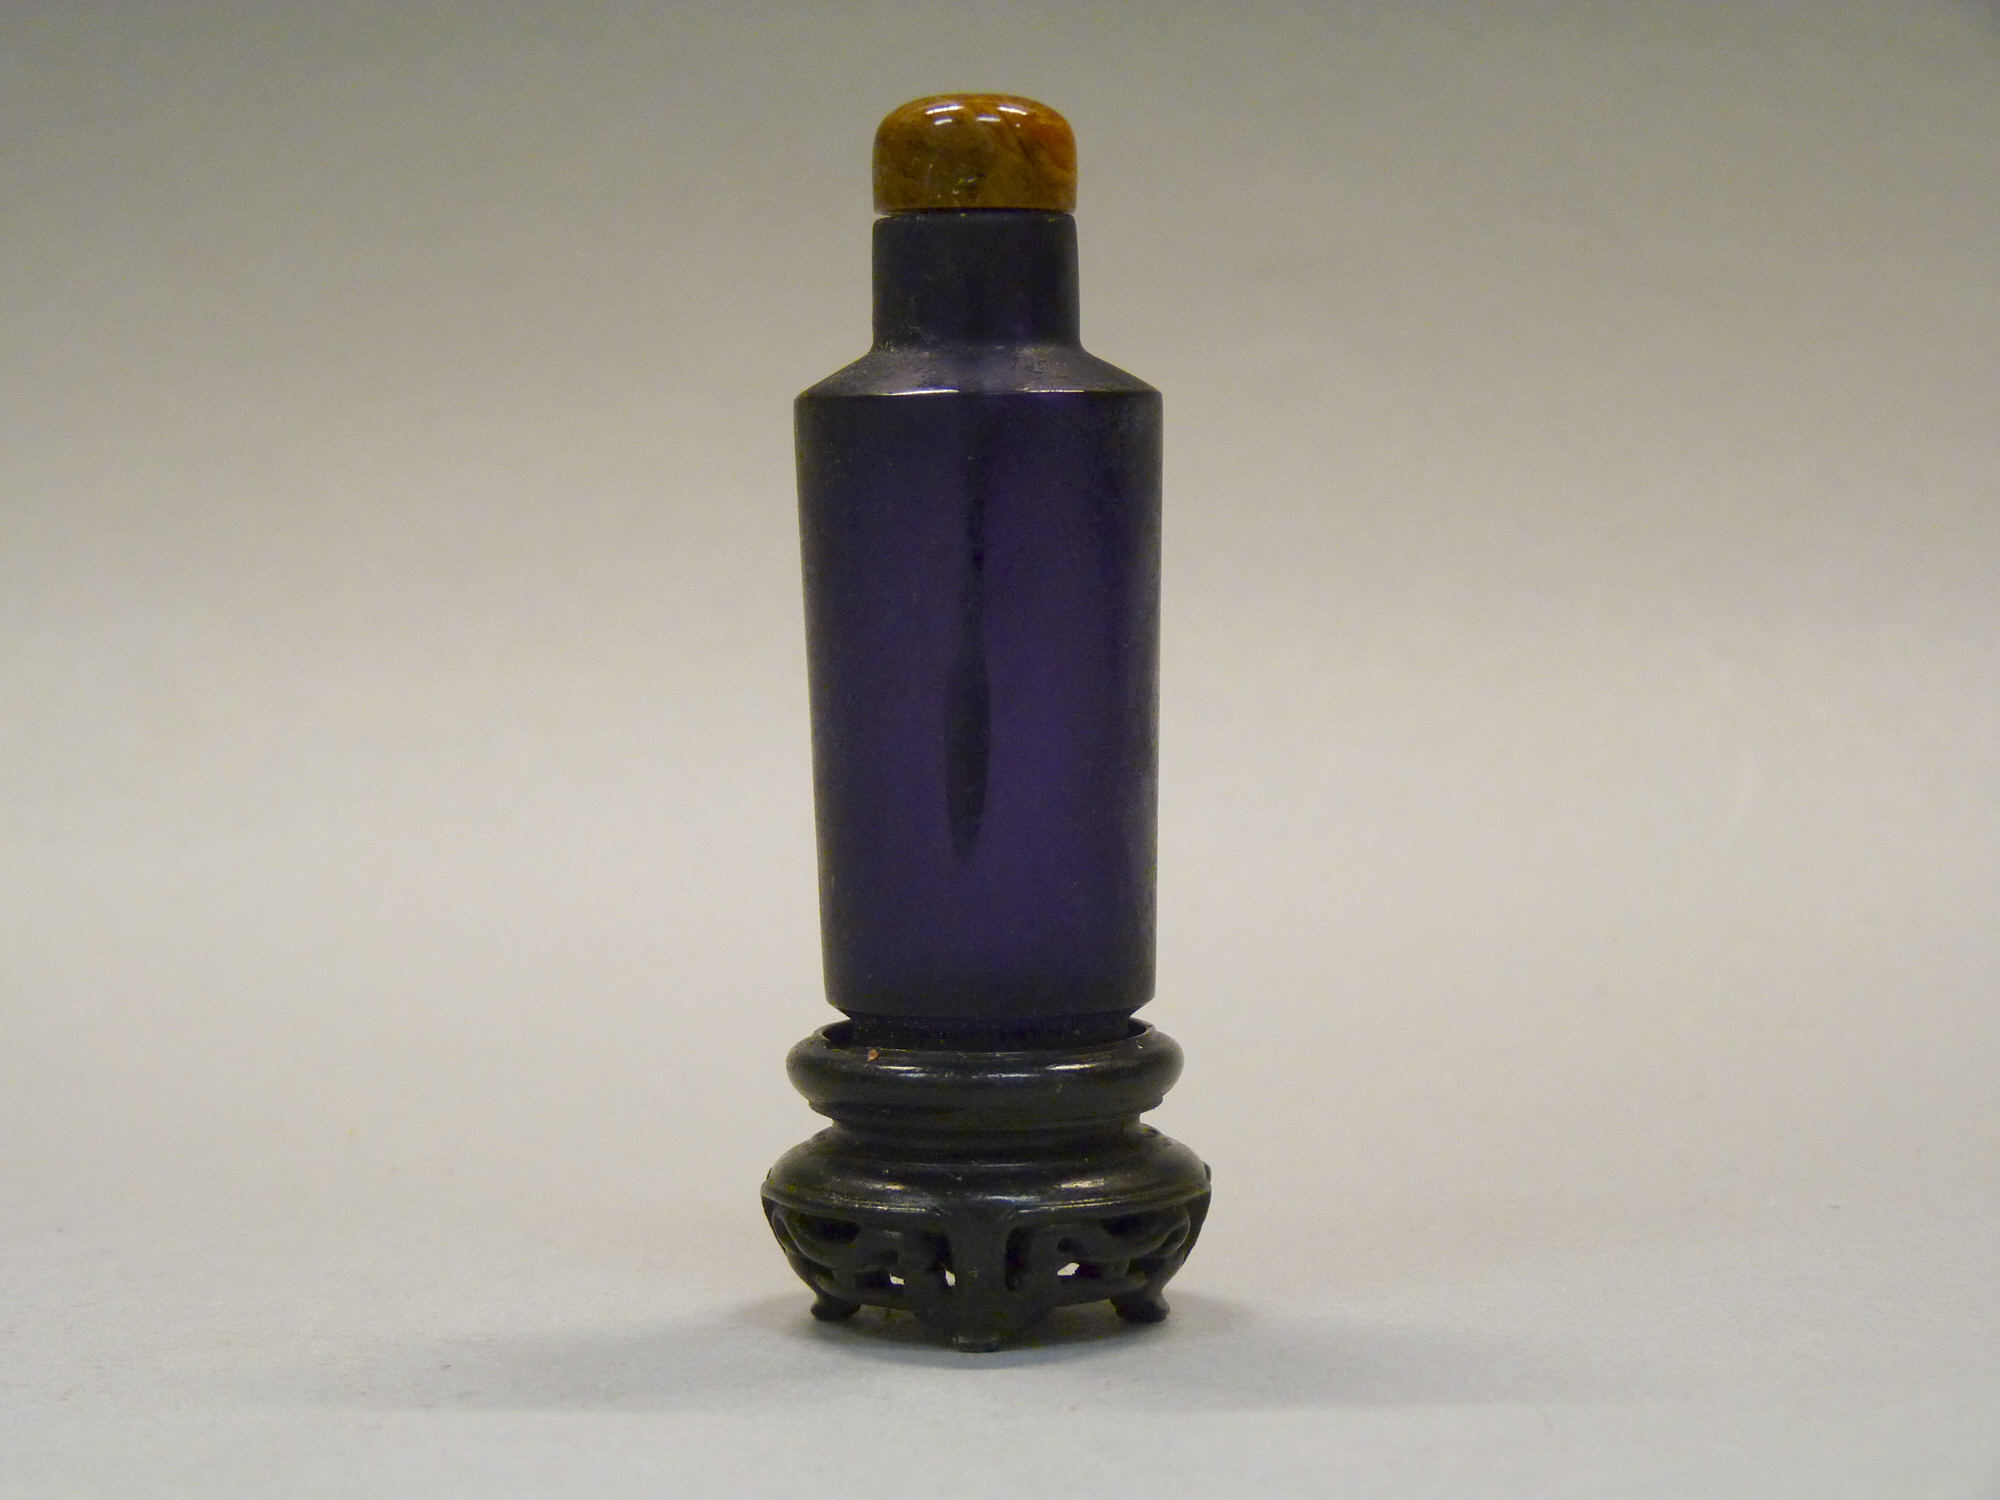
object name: snuff bottle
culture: chinese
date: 1801-1900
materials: amber, glass